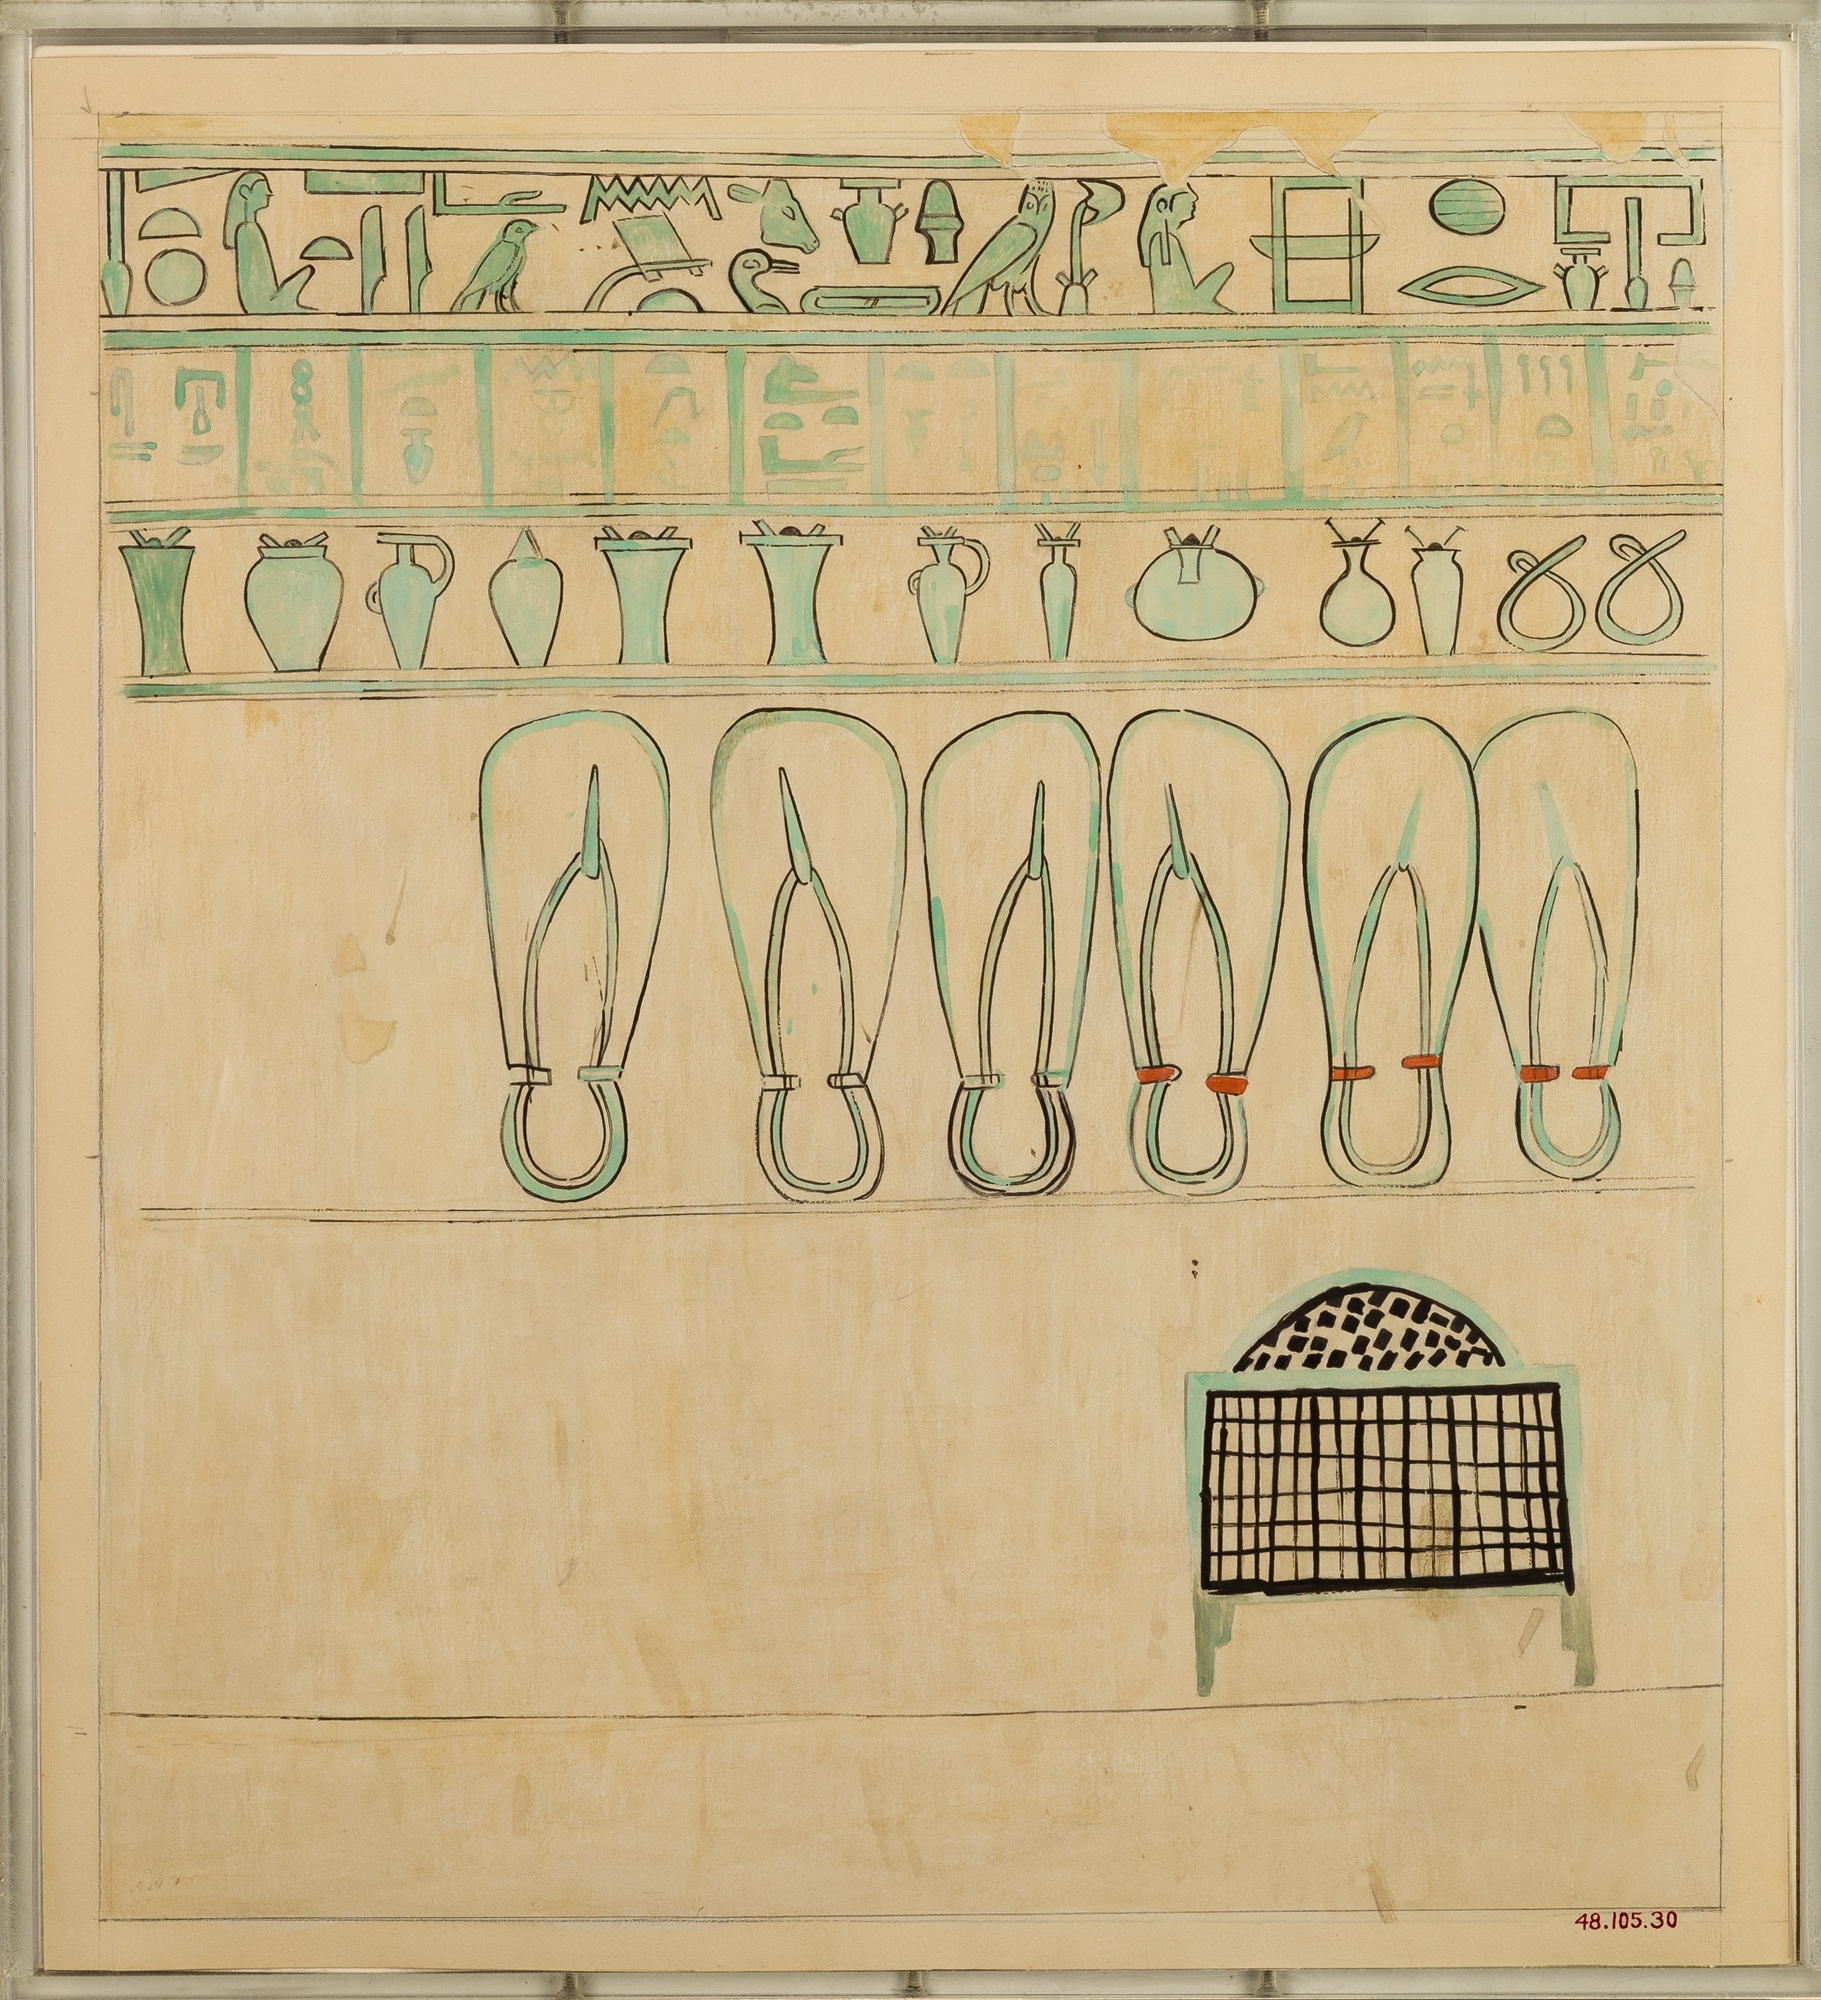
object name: facsimile, aashyt sarcophagus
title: Facsimile of the painting on the inside of the foot end of the sarcophagus of Aashyt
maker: charles k. wilkinson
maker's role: artist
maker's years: 1897-1986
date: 2051-2030 BCE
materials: paper, paint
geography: egypt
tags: hieroglyphs